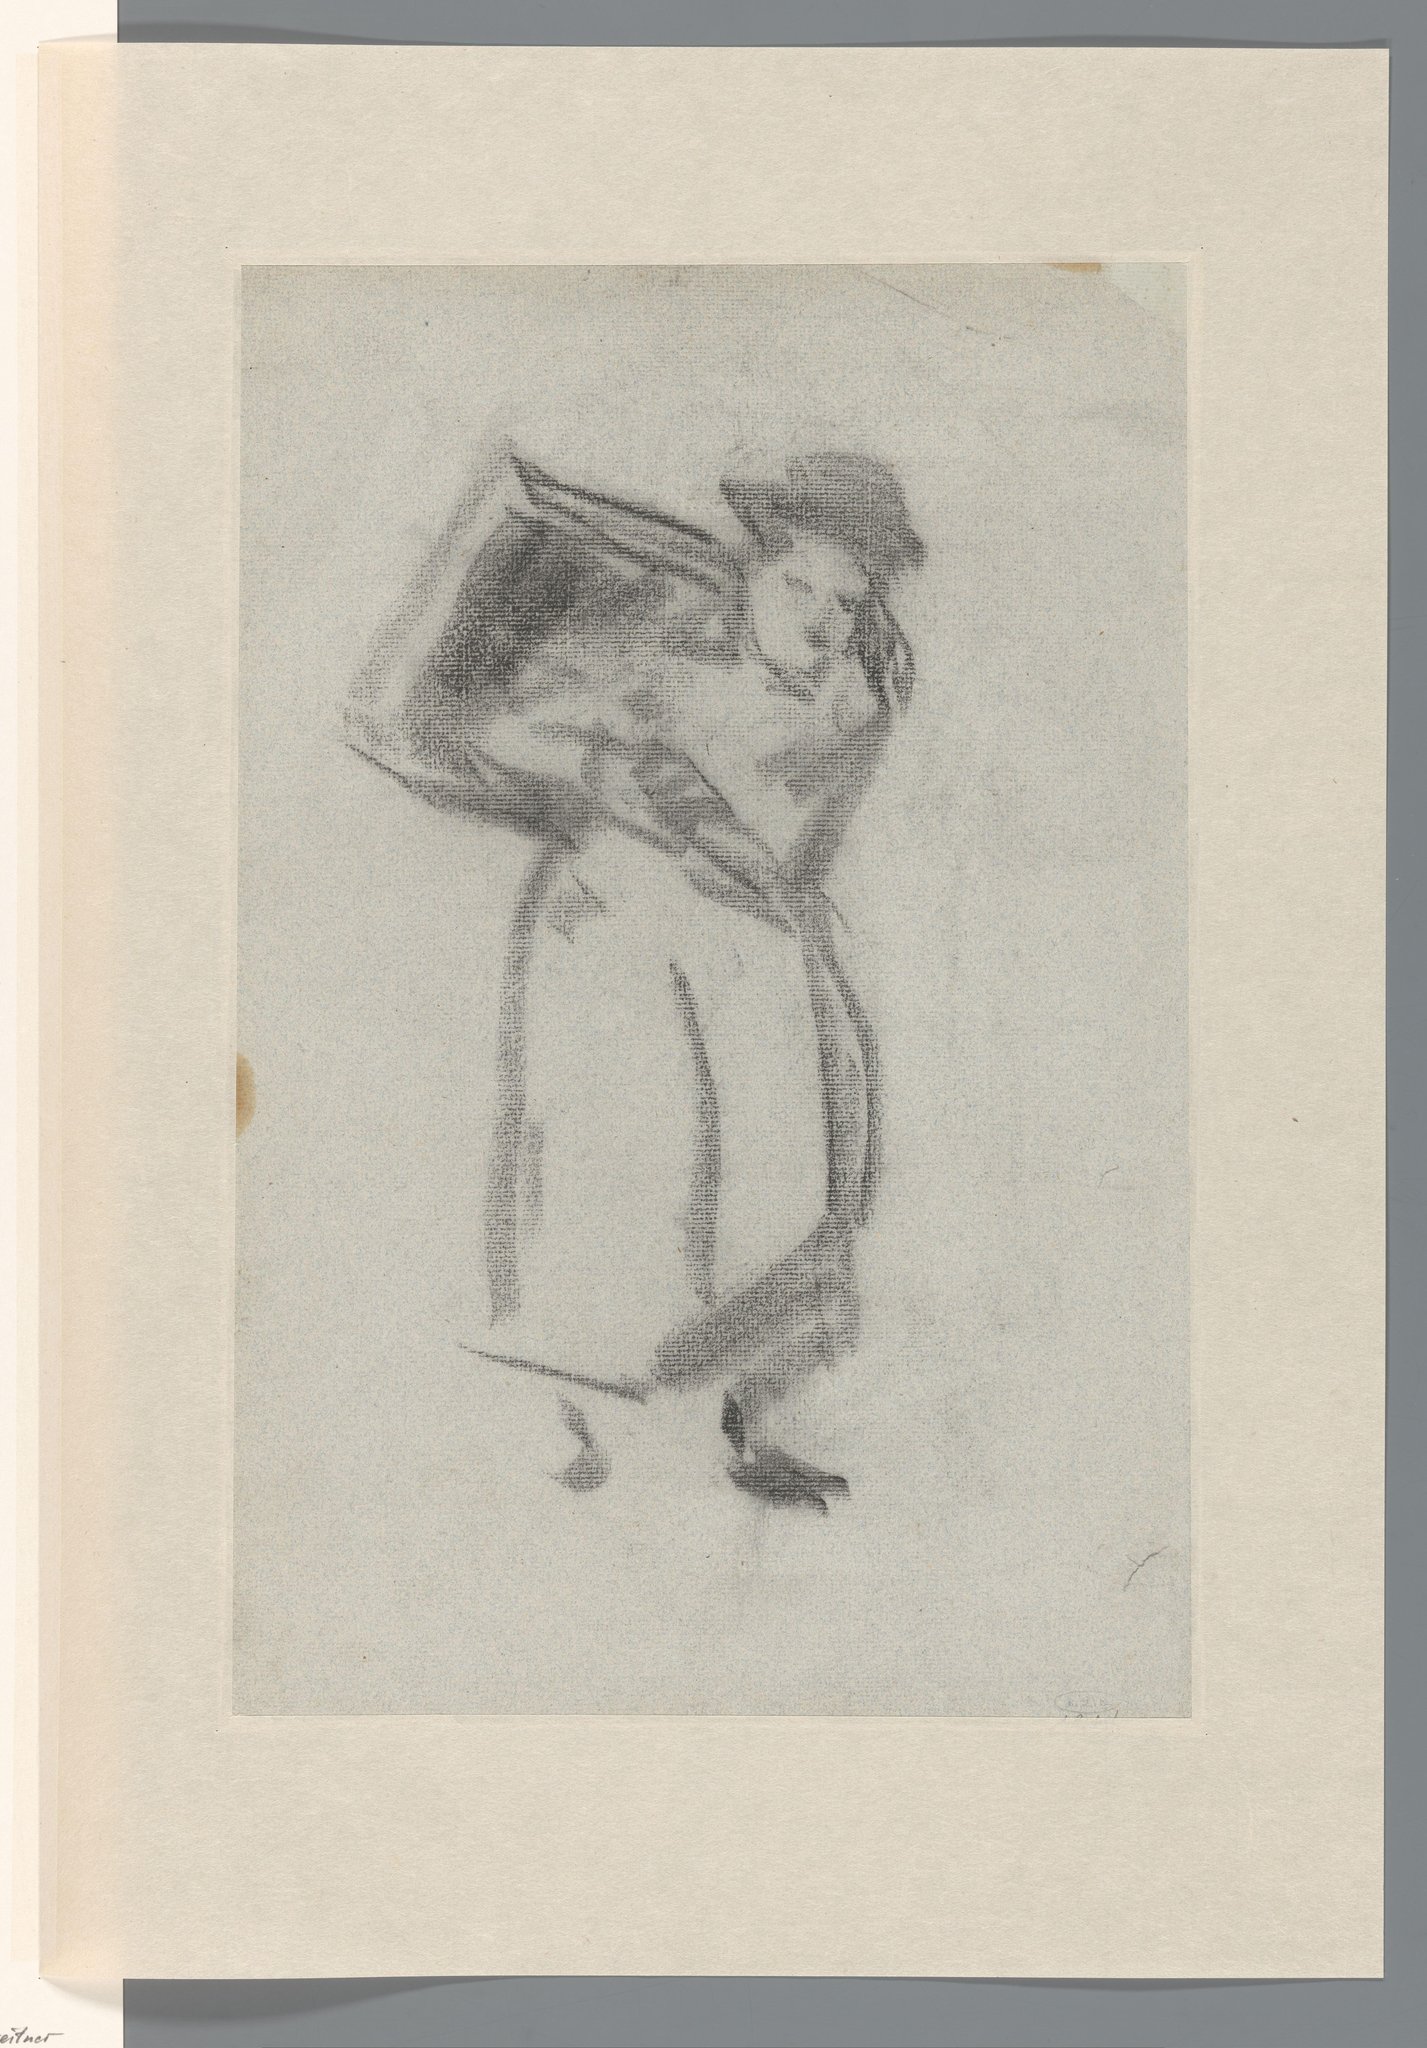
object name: drawing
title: Schets van een persoon met een last op de rug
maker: george hendrik breitner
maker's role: draughtsman, painter, print maker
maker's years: 1857-1923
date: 1867-1923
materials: chalk, paper